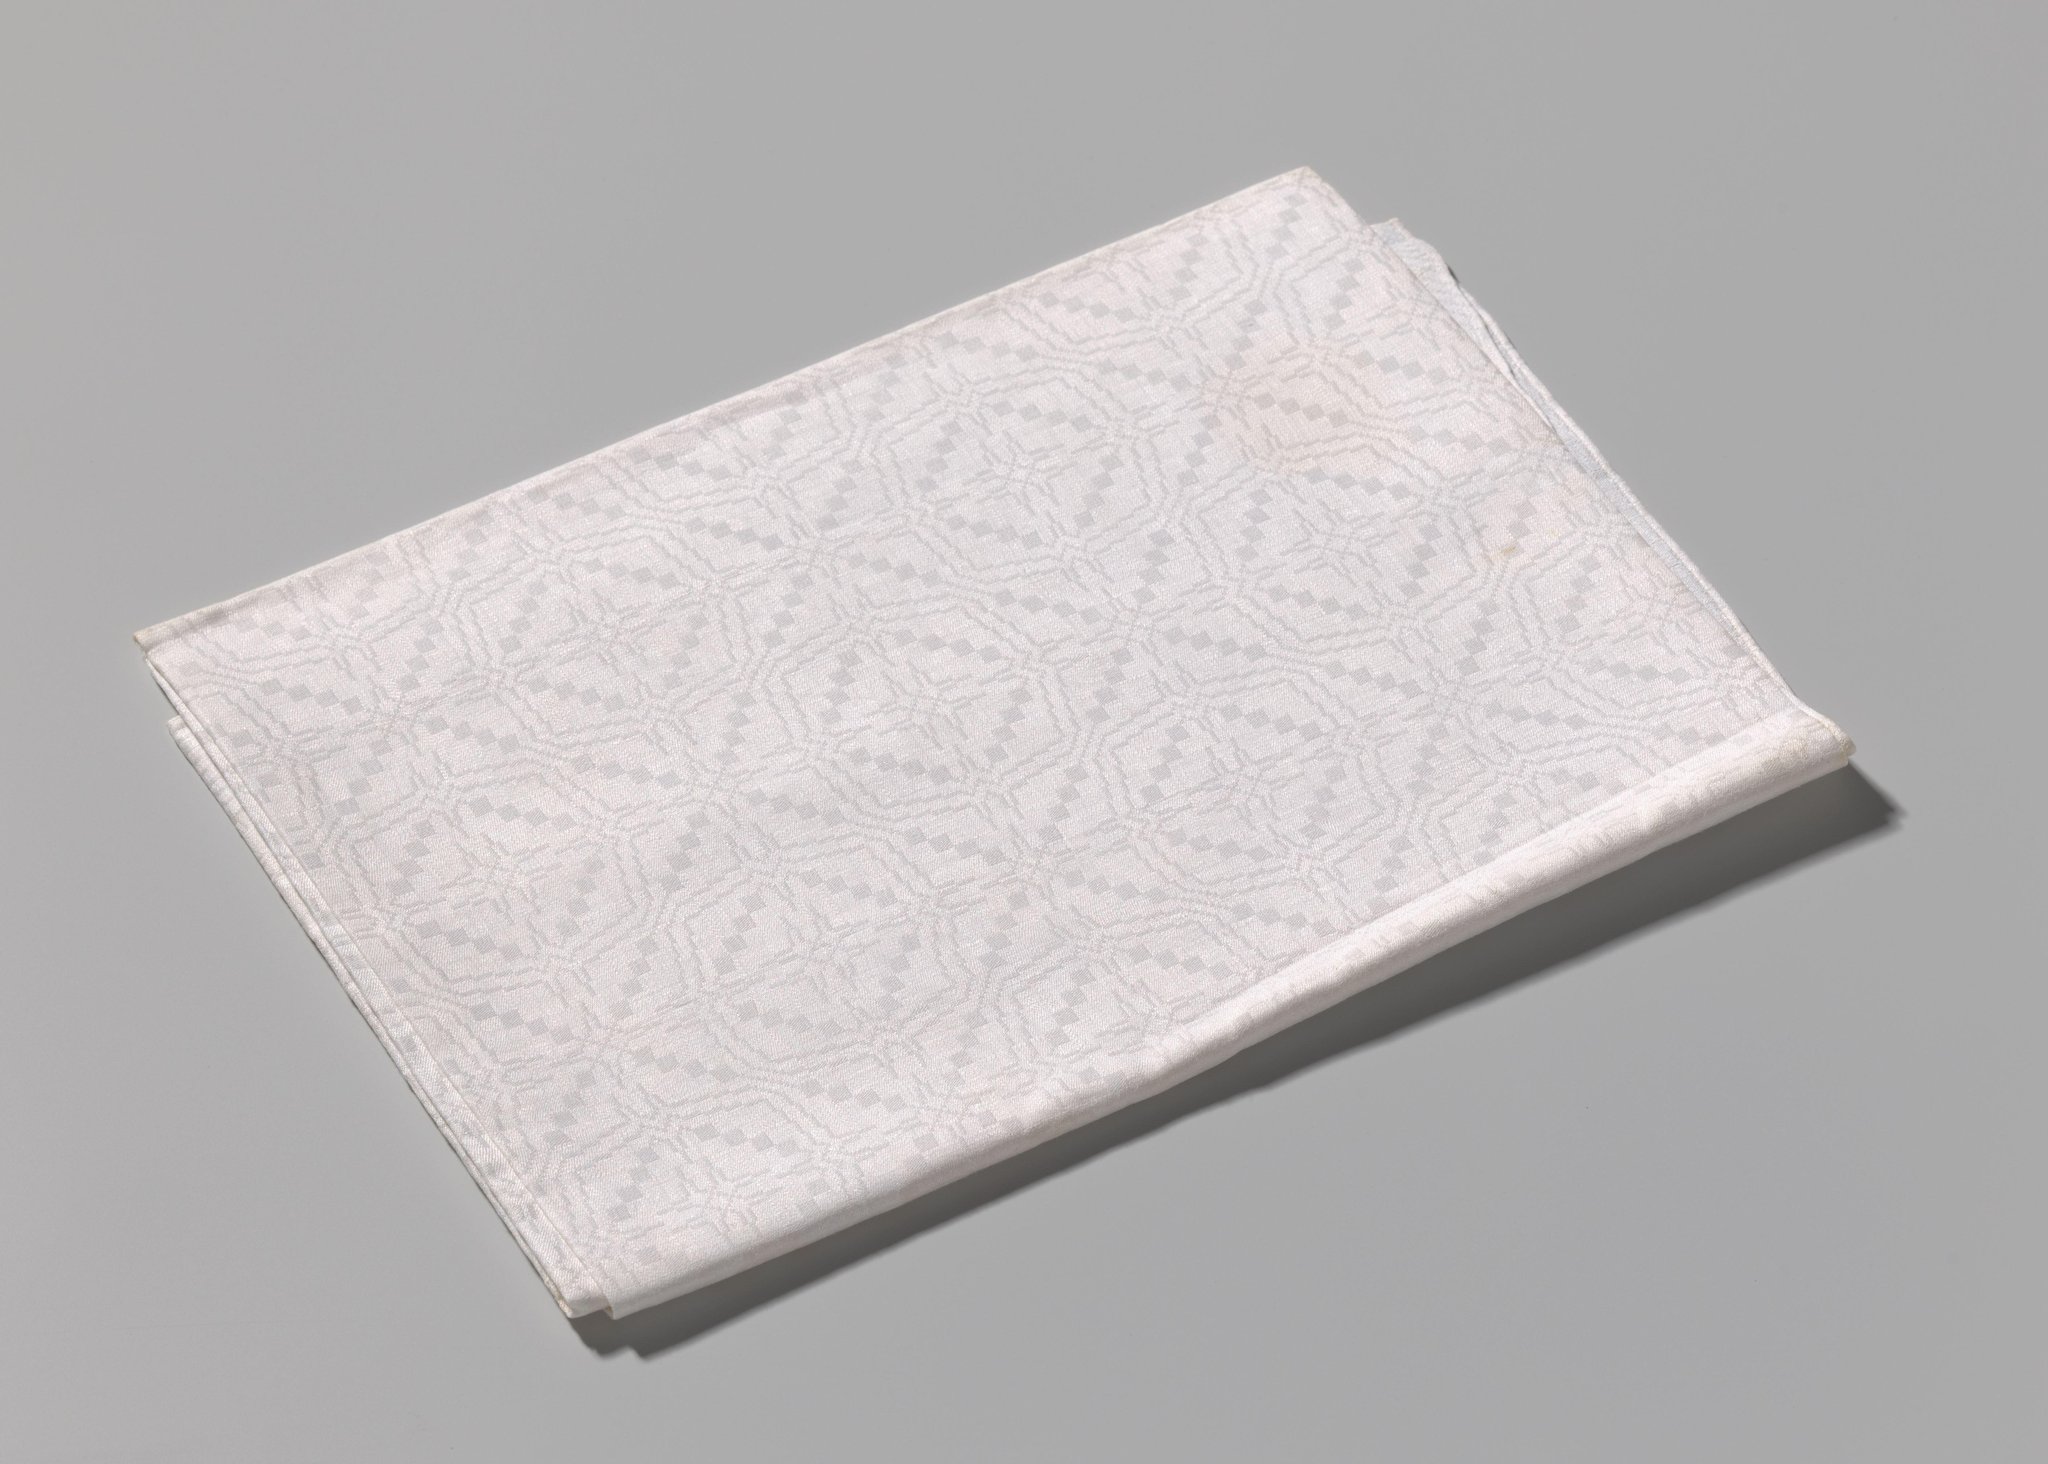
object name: napkin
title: Pellen. Merk: HW 38 p poonl.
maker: Anonymous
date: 1775-1799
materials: linen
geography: netherlands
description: Servet van wit linnen met een pellen patroon en randen, merk HW 38 p poonl.